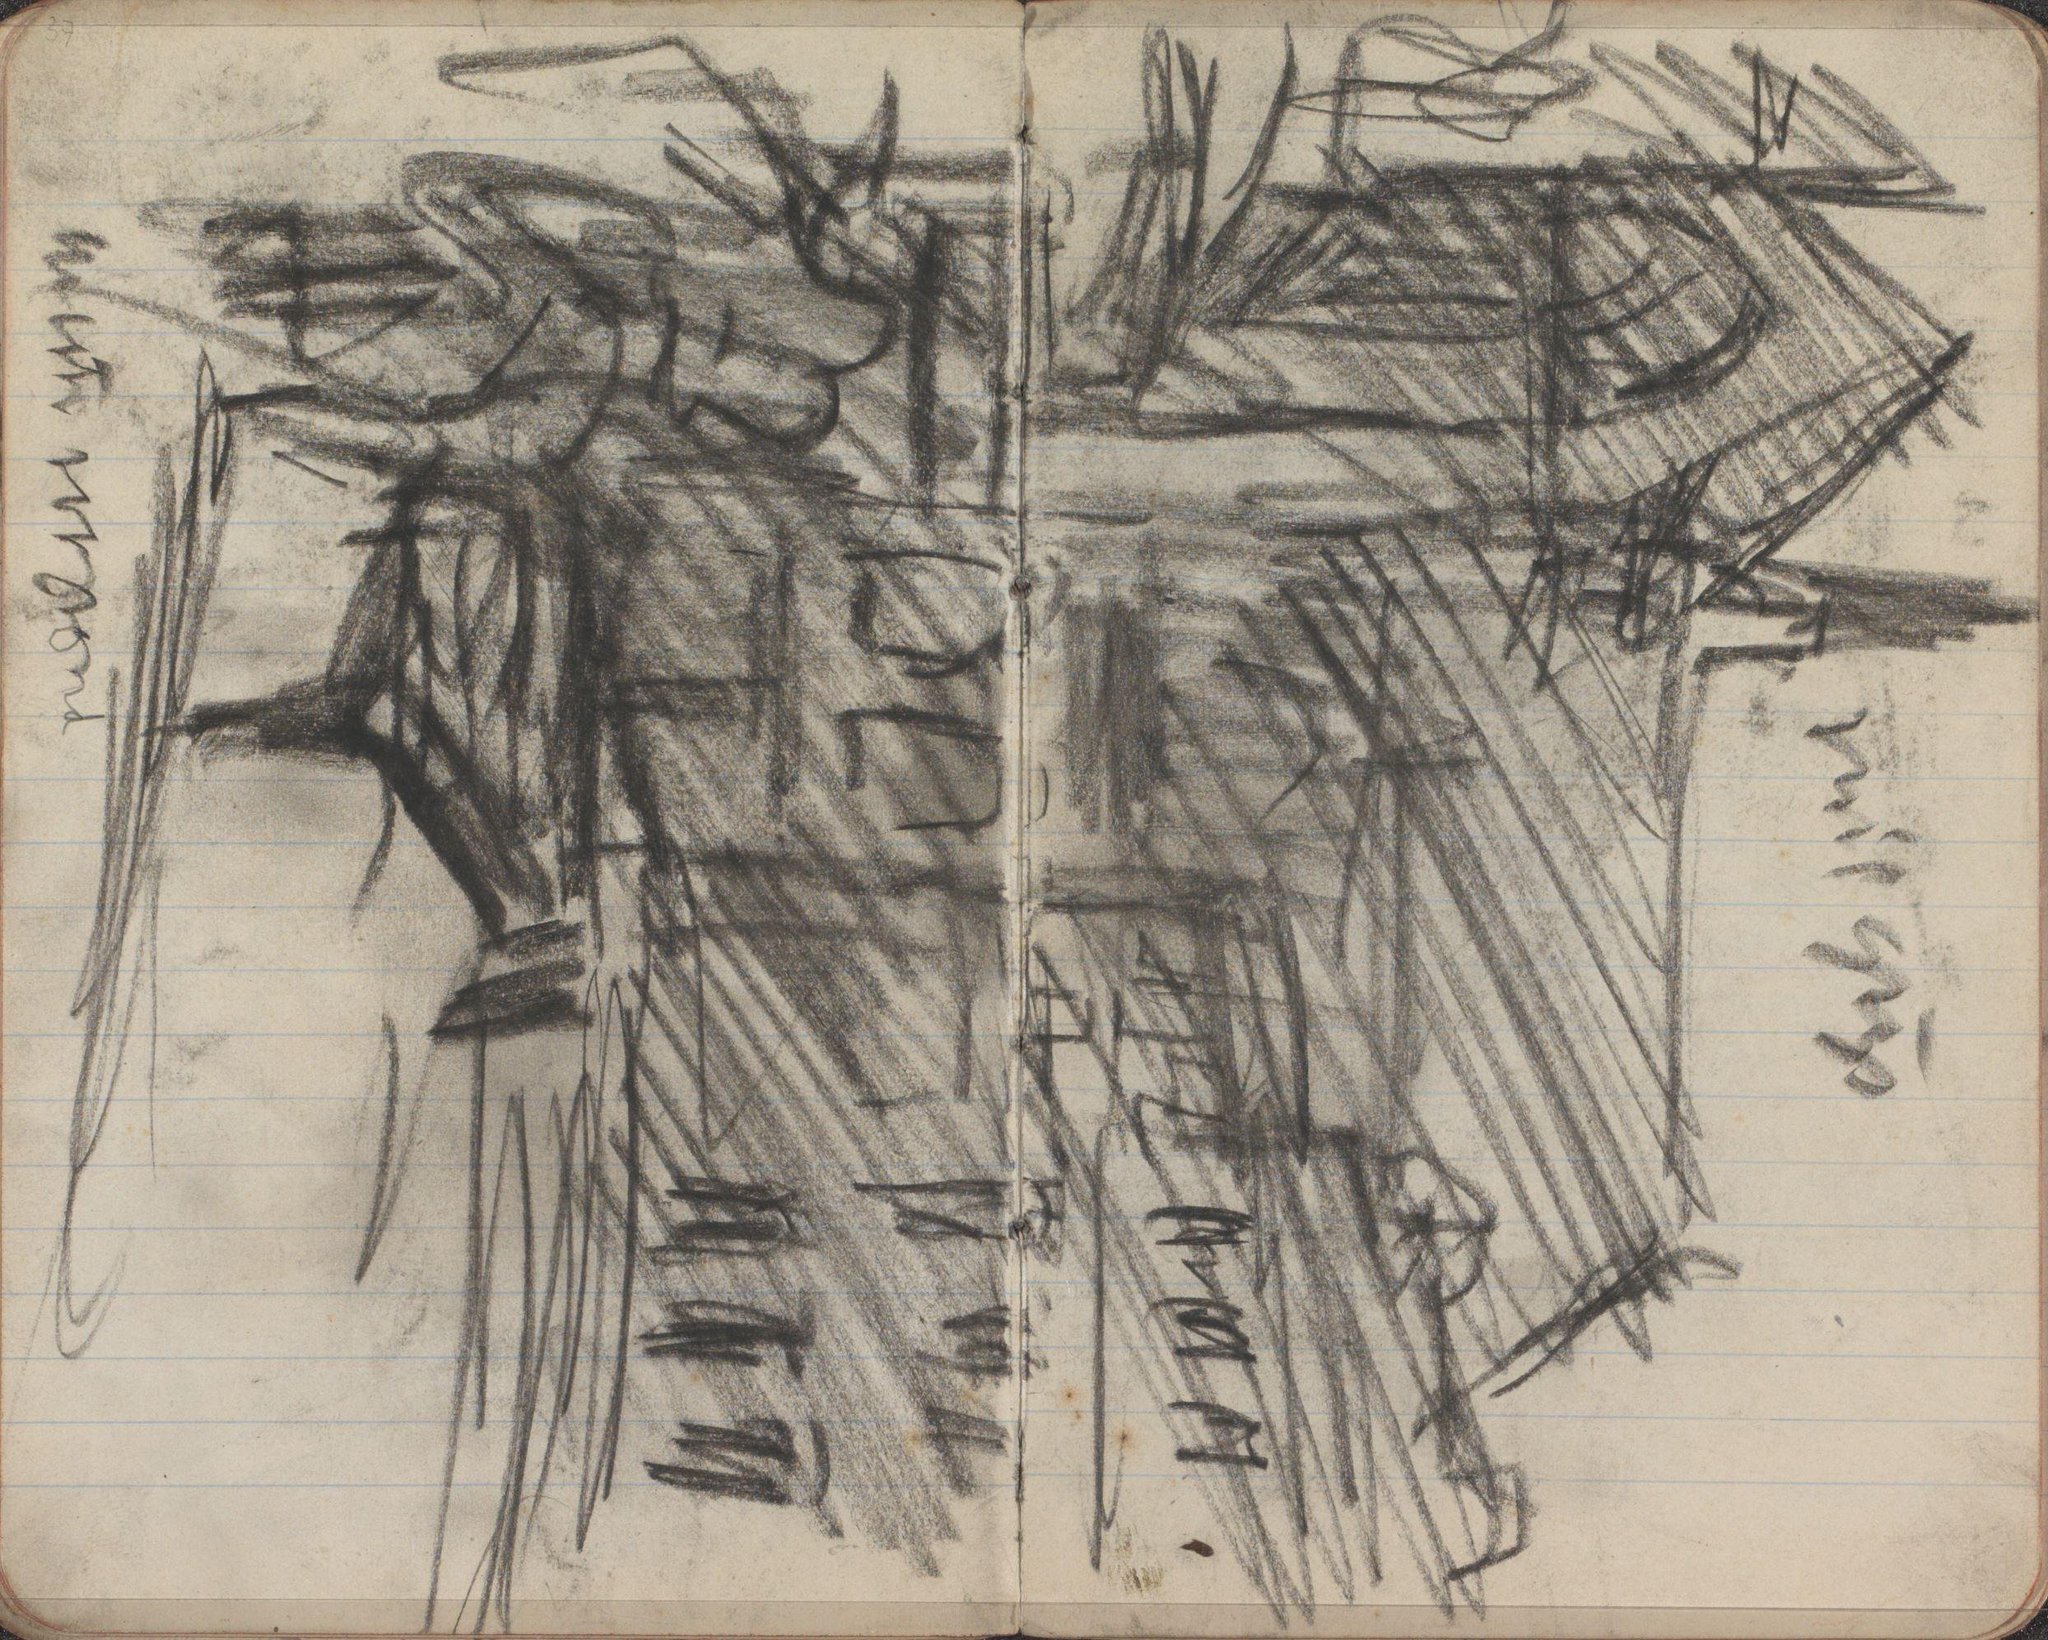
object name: sketchbook leaf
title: Gezicht op de Dam te Amsterdam met de Nieuwe Kerk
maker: george hendrik breitner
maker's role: draughtsman, painter, print maker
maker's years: 1857-1923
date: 1893-1898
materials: chalk, paper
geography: amsterdam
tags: square, place, circus, etc., church (exterior), horse, royal palace of amsterdam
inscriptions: kleurnotitie, handgeschreven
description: Links een deel van het Koninklijk Paleis. Vooraan een aangespannen paard. Pagina 37 en pagina 38 uit een schetsboek met 38 bladen.